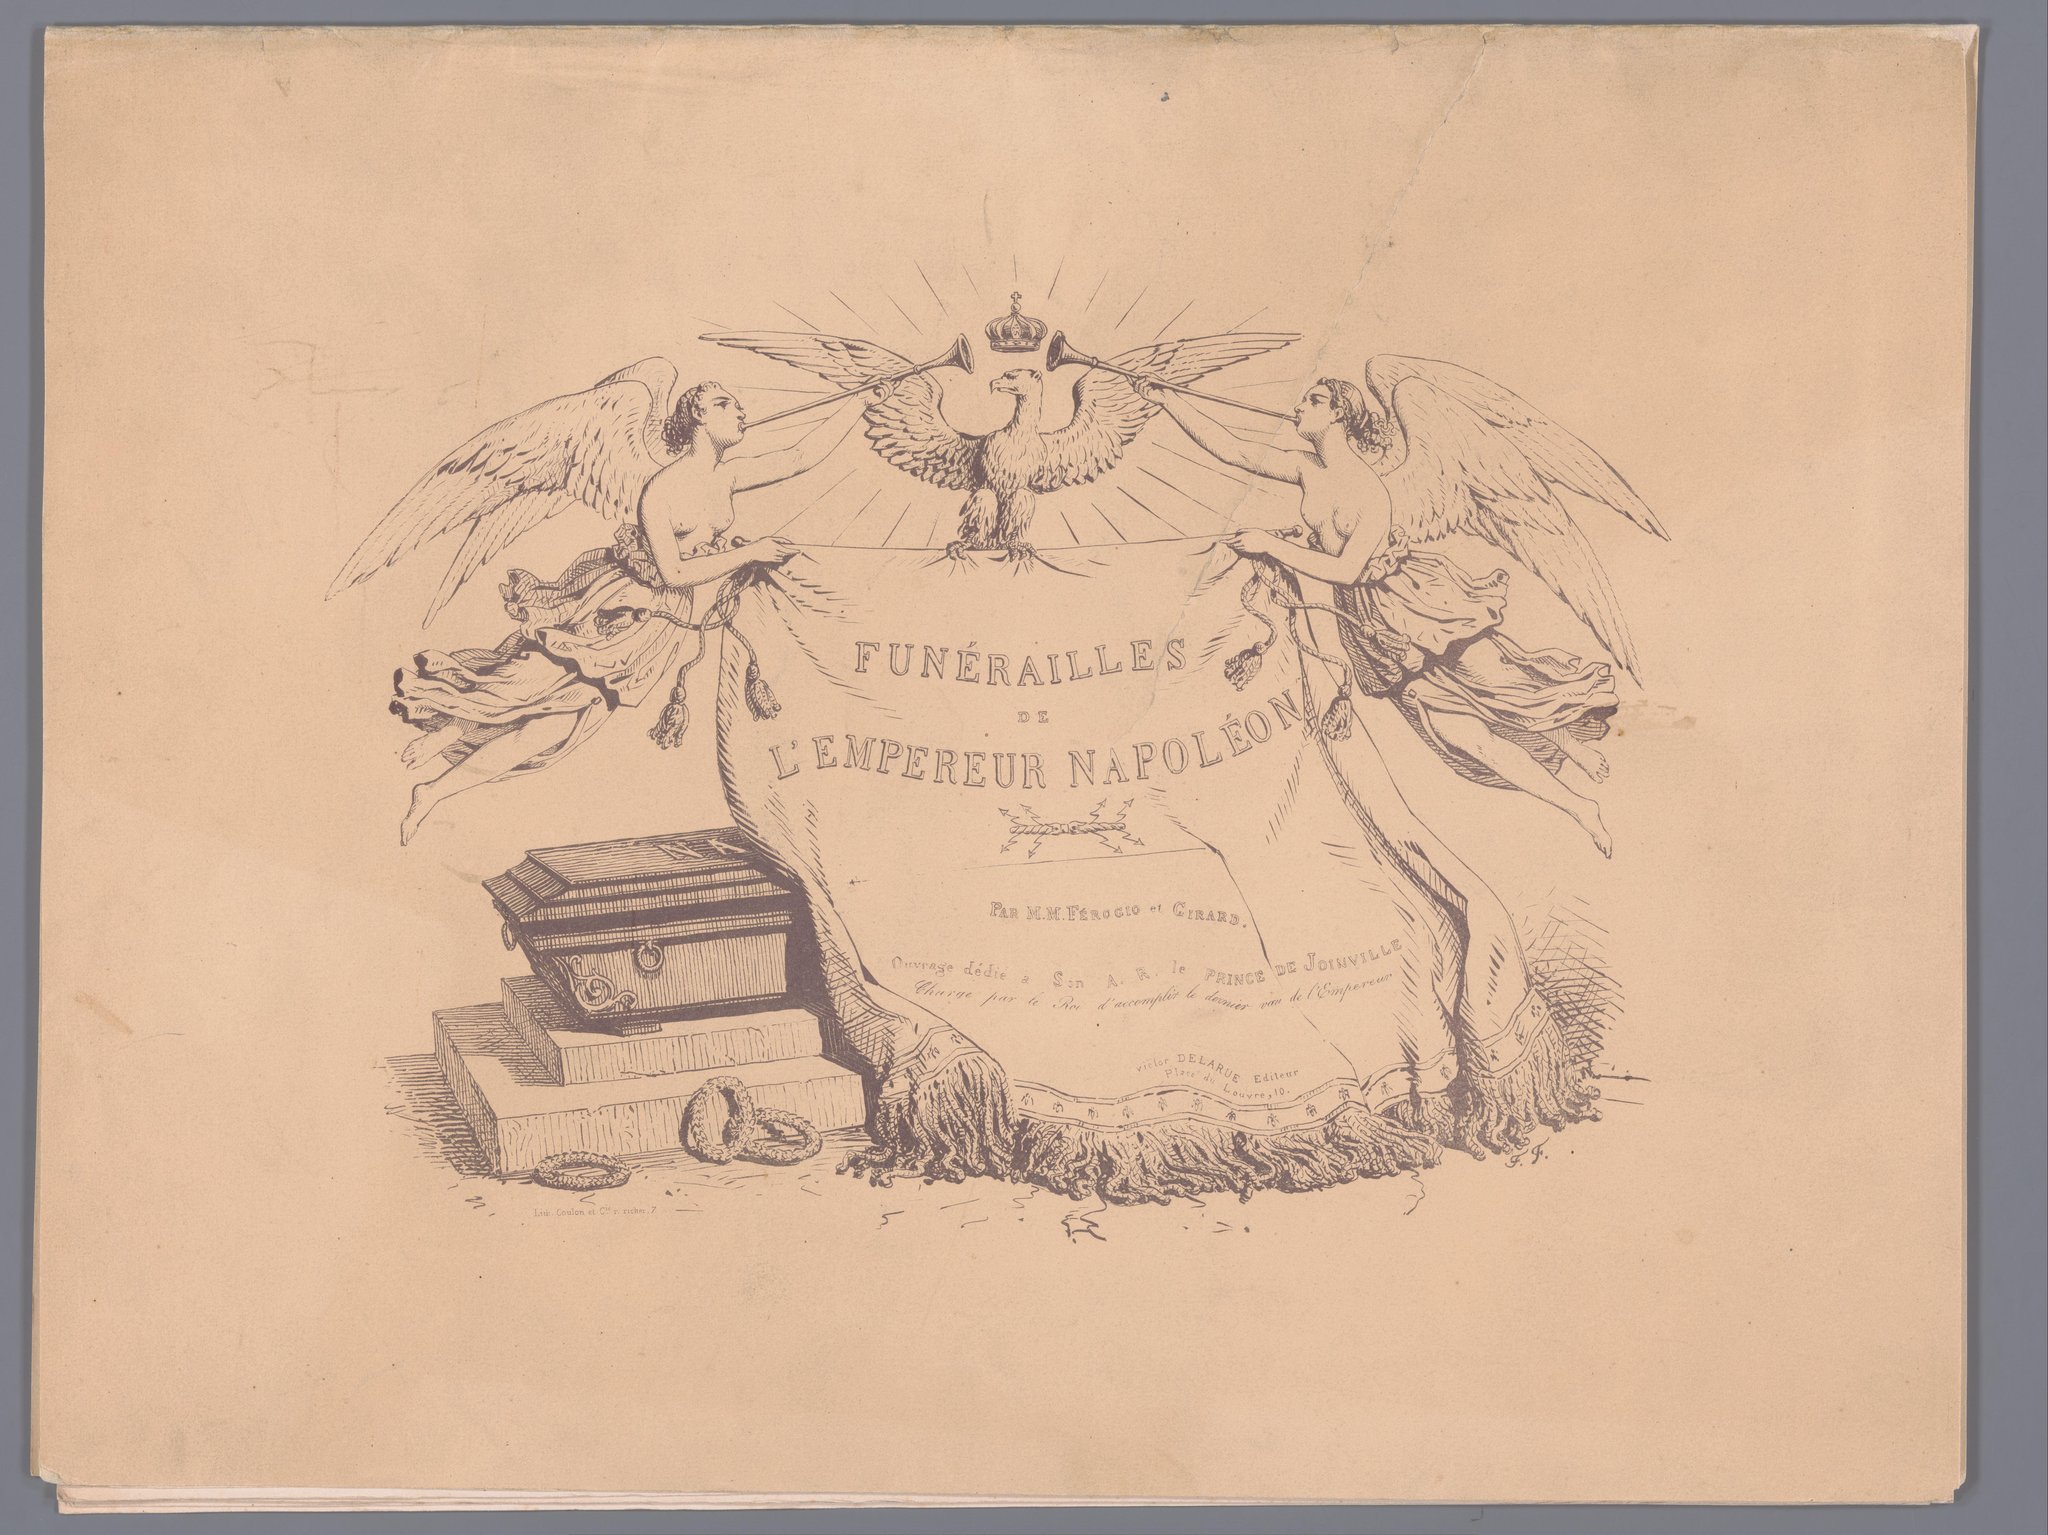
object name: wrapper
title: Omslag voor: Uitvaartceremonie van keizer Napoleon Bonaparte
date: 1841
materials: paper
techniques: pen lithography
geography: paris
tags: coffin, funerary ceremonial, angels